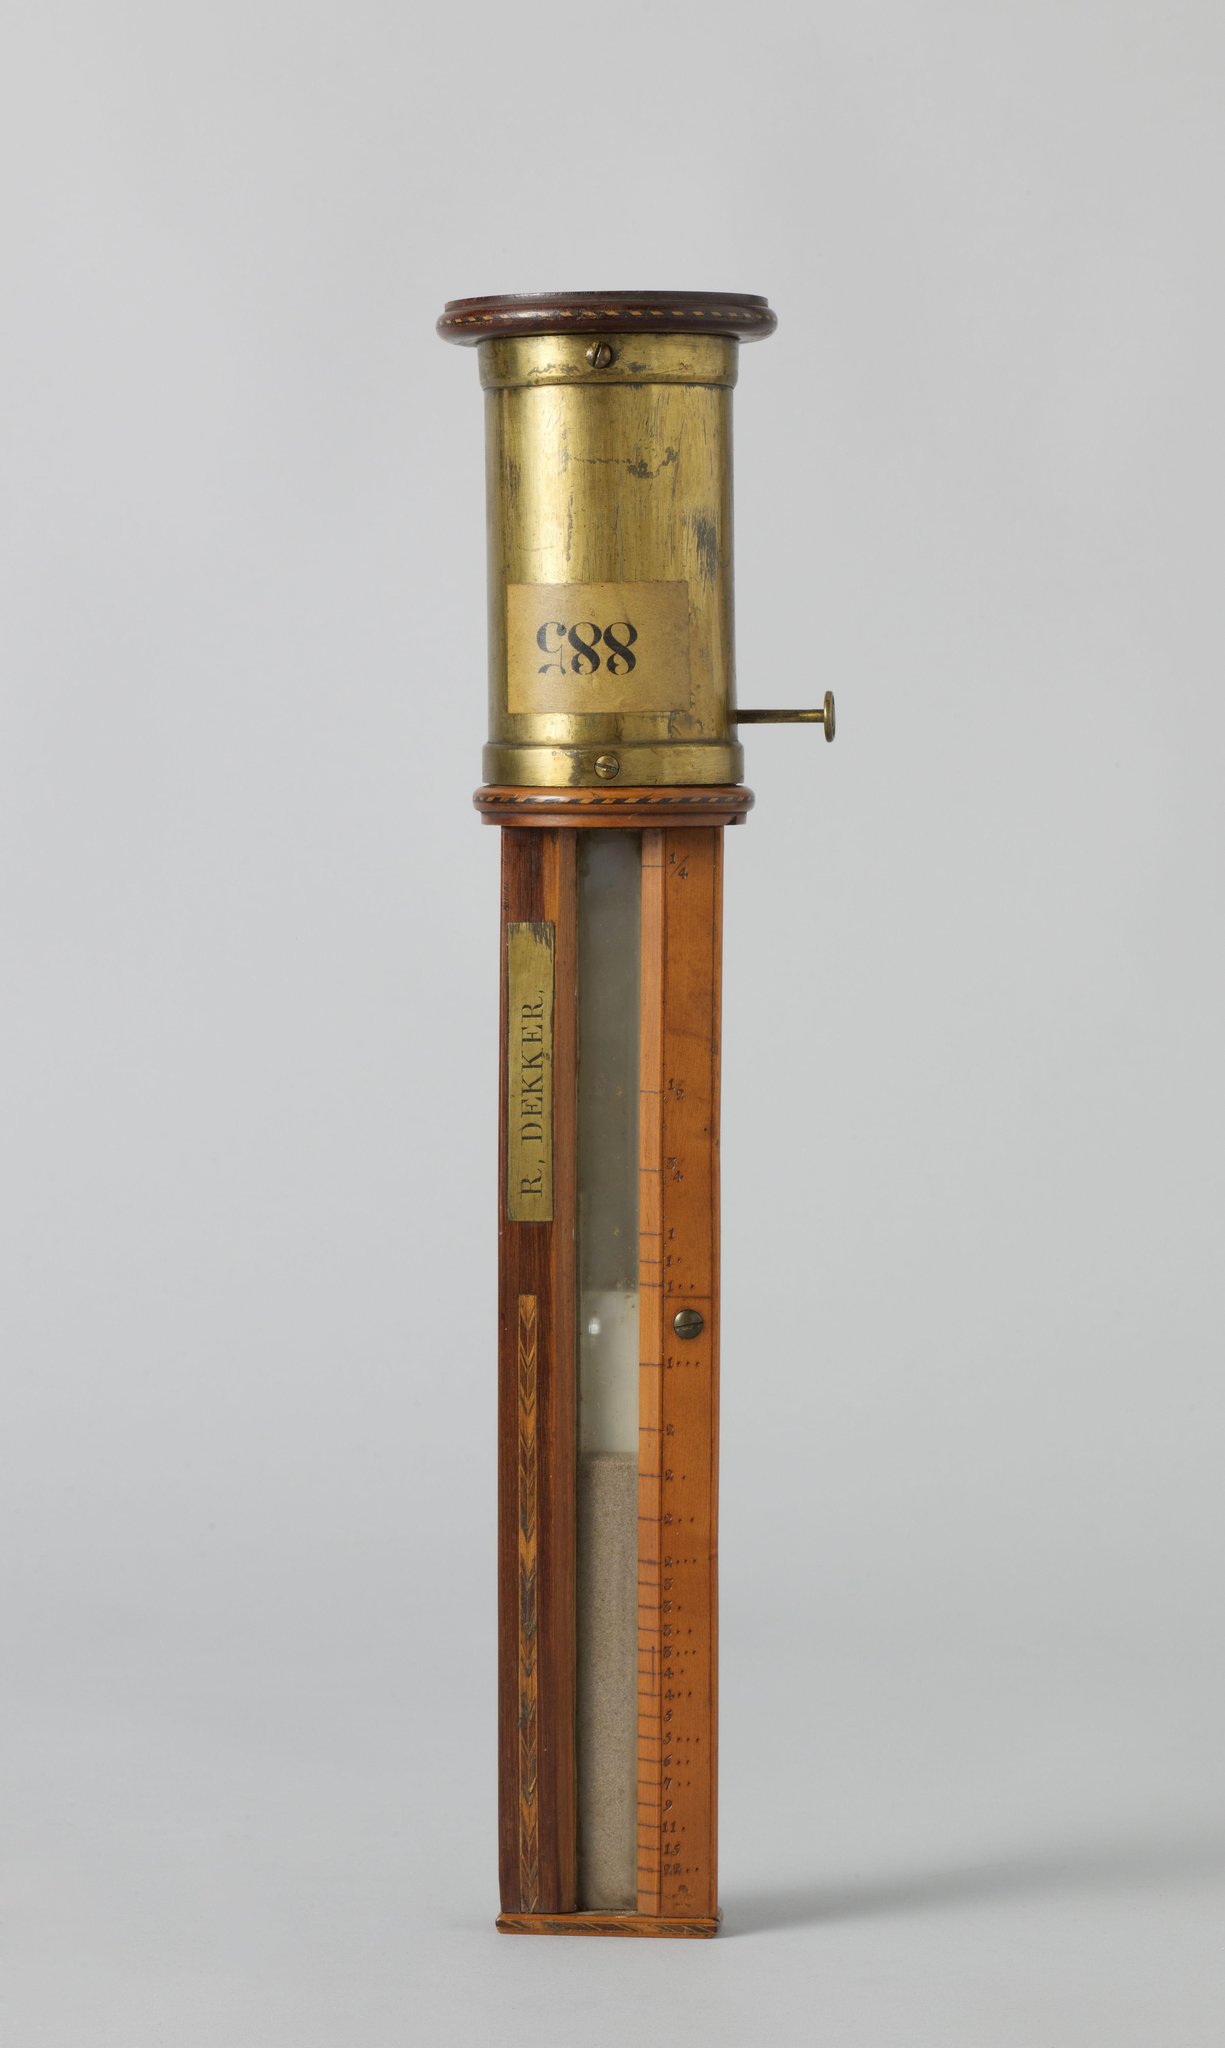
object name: measuring instrument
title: Log Timer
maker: rasmus dekker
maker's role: instrument maker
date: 1795-1812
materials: brass, glass, mineral, wood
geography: amsterdam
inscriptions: inscription, near the brass casing: ‘R. DEKKER’, label, on the brass casing: ‘885’ former inventory label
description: Het instrument was bedoeld om de vaart van het schip te bepalen in combinatie met het gewone log of door de snelheid waarmee schuim langs het boord loopt te meten; gewoonlijk werd dit door eenvoudig tellen gedaan. Dekker heeft tussen 1791 en 1815 herhaalde pogingen ondernomen om zijn uitvindingen bij de (Nederlandse en Franse) overheid te slijten, maar werd steeds afgewezen. In 1810 werden zijn instrumenten door Lantsheer beproefd, en in 1814 werden instrumenten aangeschafd voor verder proefnemeningen. In 1817 werden de uitvindingen door de Marine definitief als onvoldoende afgewezen. Dekker kreeg 16 dukaten ter renumeratie voor zijn logteller in 1812.